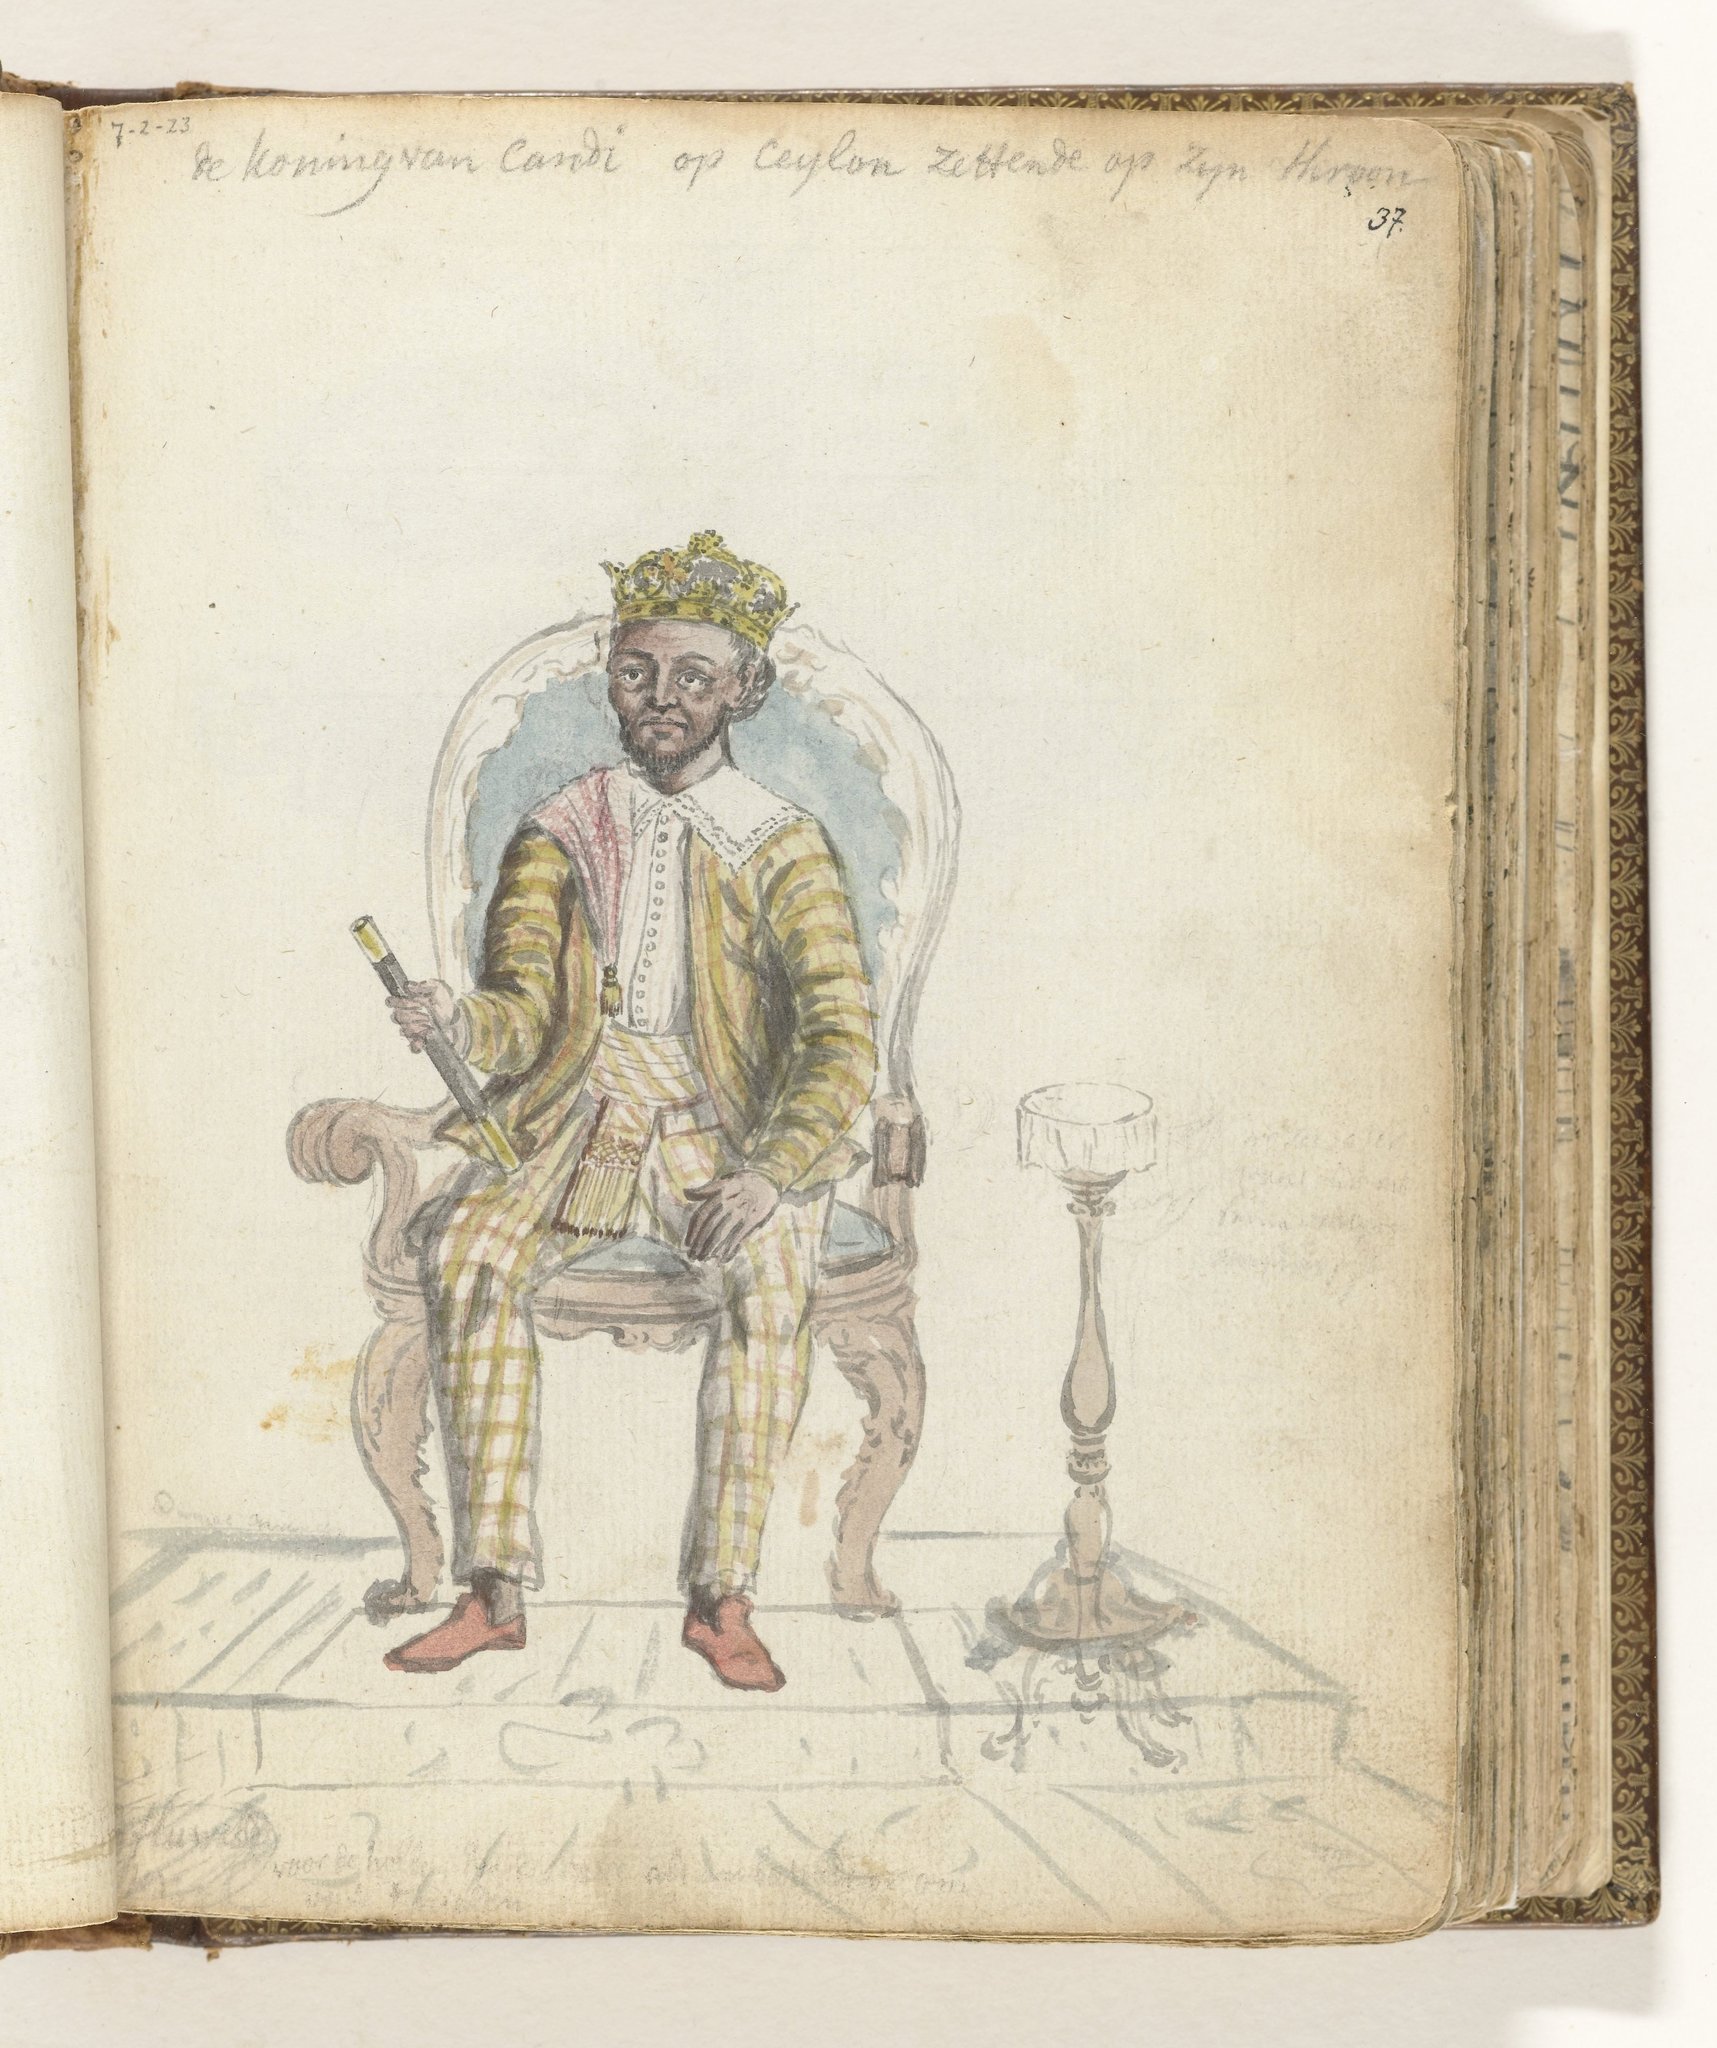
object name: drawing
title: The King of Kandy, Sri Rajadi Raja Sinha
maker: jan brandes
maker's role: draughtsman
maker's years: 1743-1808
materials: paper, pencil, watercolor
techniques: brush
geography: colombo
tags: historical persons, king, sri lanka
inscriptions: inscription: ‘de koning van Candi op Ceylon zittende op zyn throon’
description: Kleurtekening van de koning van Kandy met kroon, rode muilen en in een geruit pak houdende een papierrol. Met opschrift. Onderdeel uit het schetsboek van Jan Brandes, dl. 2 (1808), p. 37.